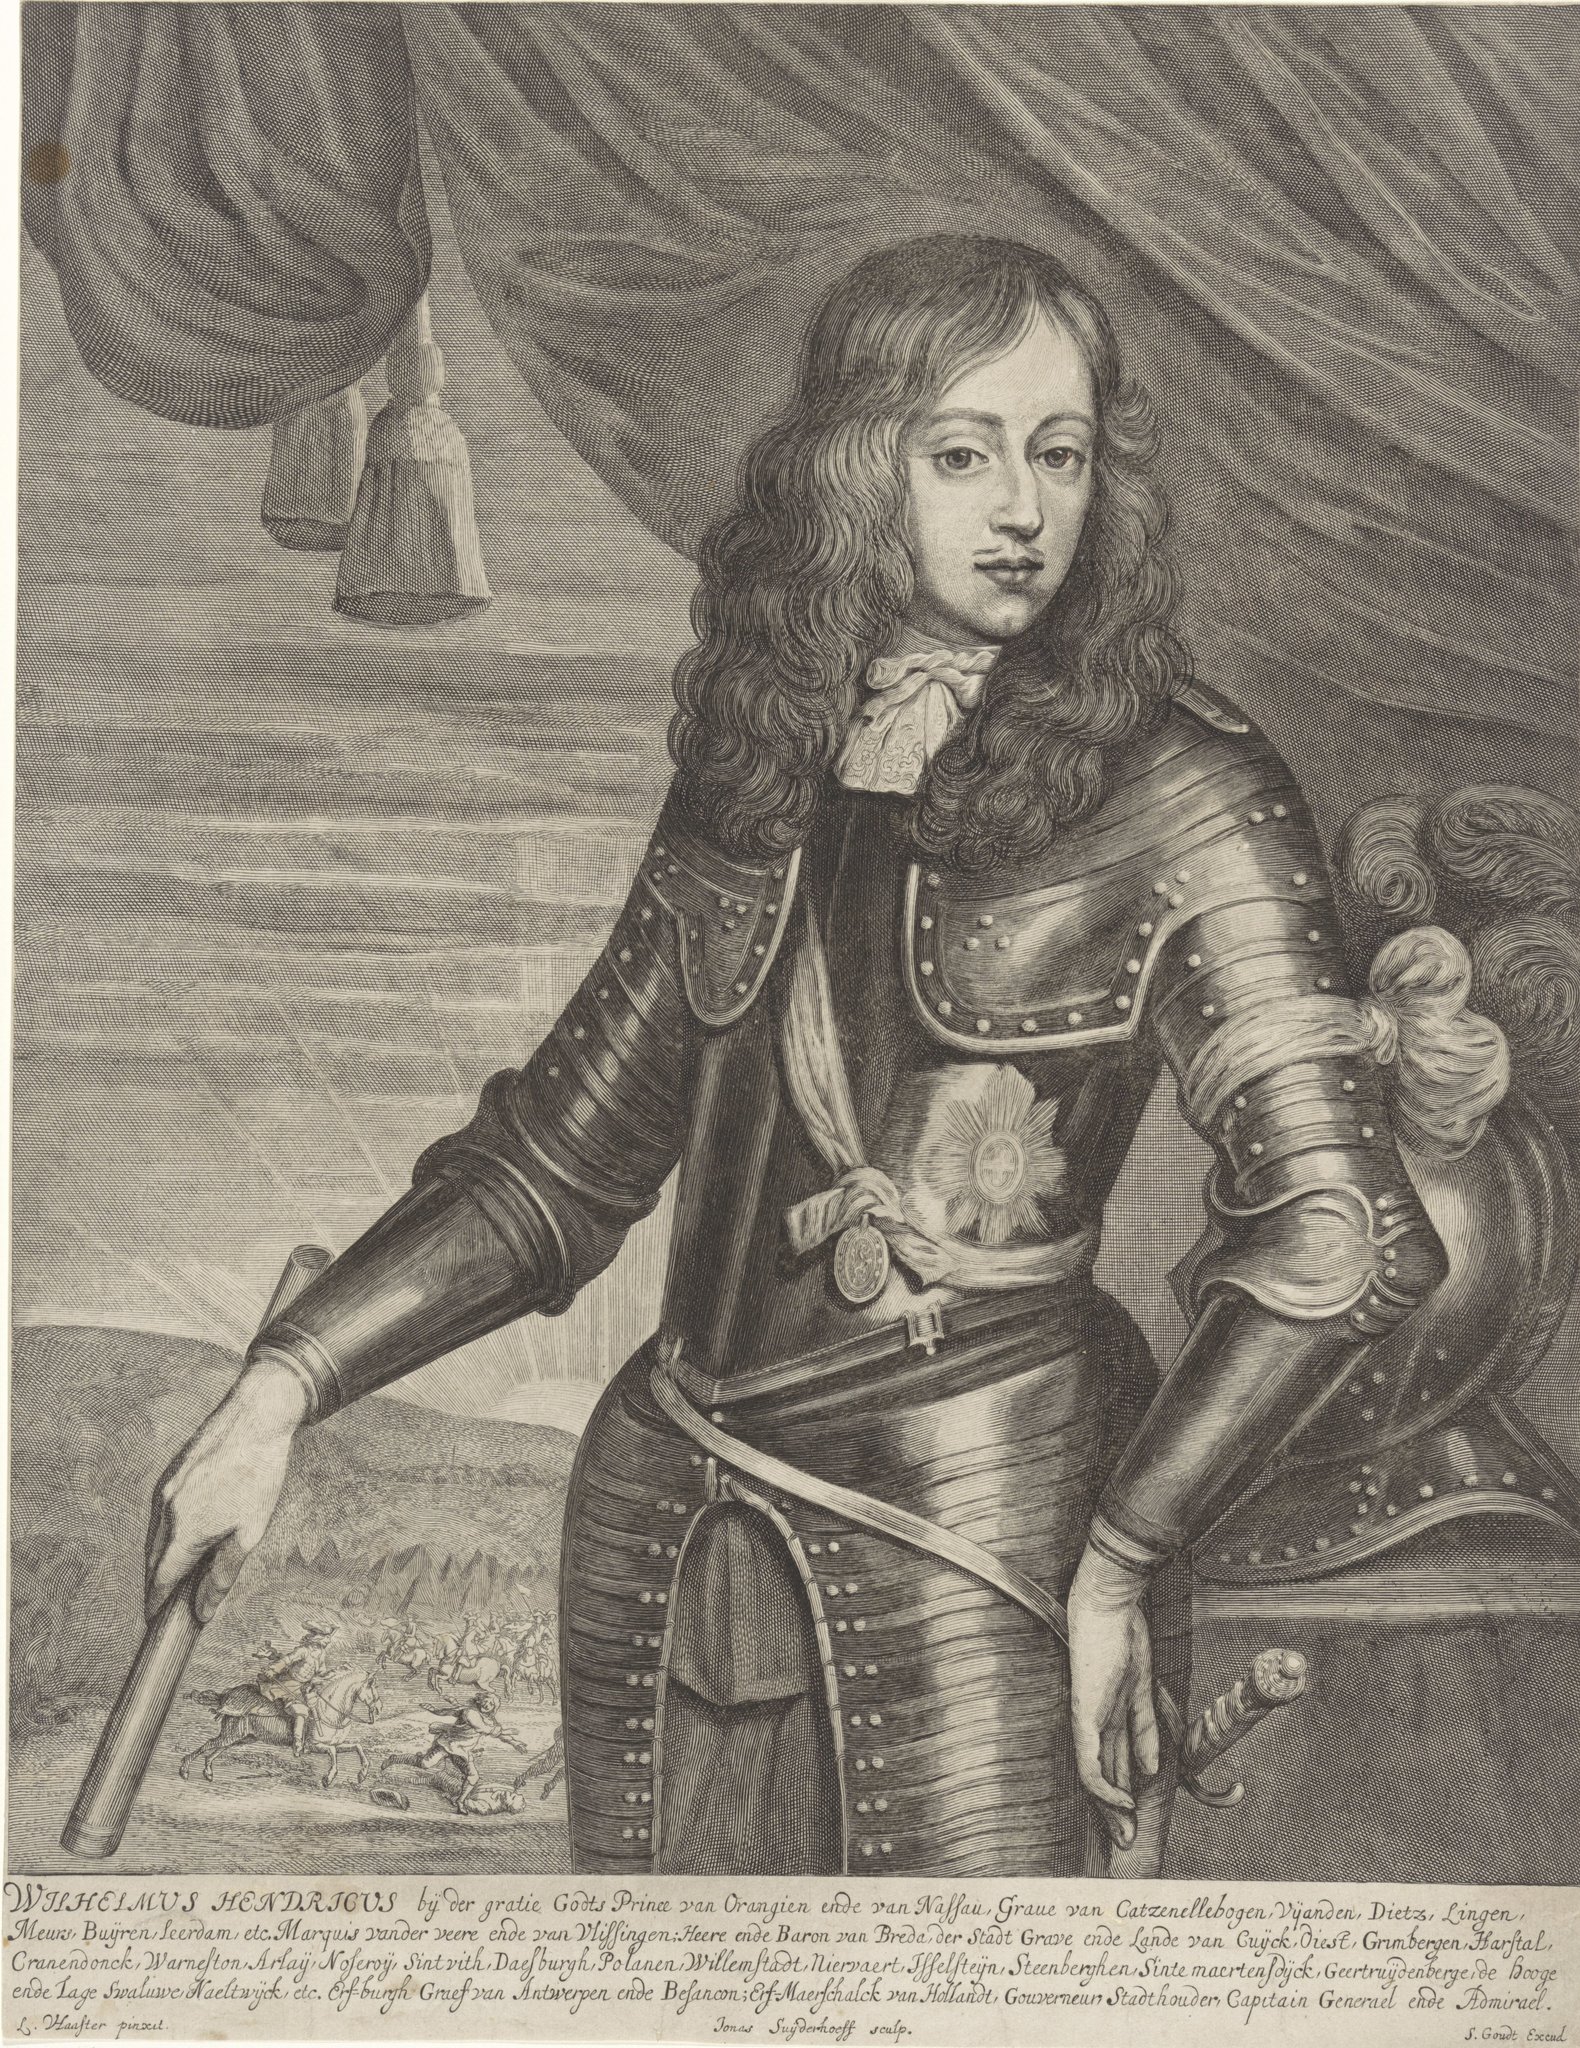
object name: print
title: Portret van Willem III, prins van Oranje-Nassau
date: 1660-1686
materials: paper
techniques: engraving, etching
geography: haarlem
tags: the hague, william iii (prince of orange and king of england, scotland, and ireland), armour, baton of general, crown prince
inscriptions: collector's mark: Lugt 2228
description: Portret van Willem III, prins van Oranje-Nassau, gekleed in harnas met een commandostaf in de hand. Op de achtergrond een veldslag.